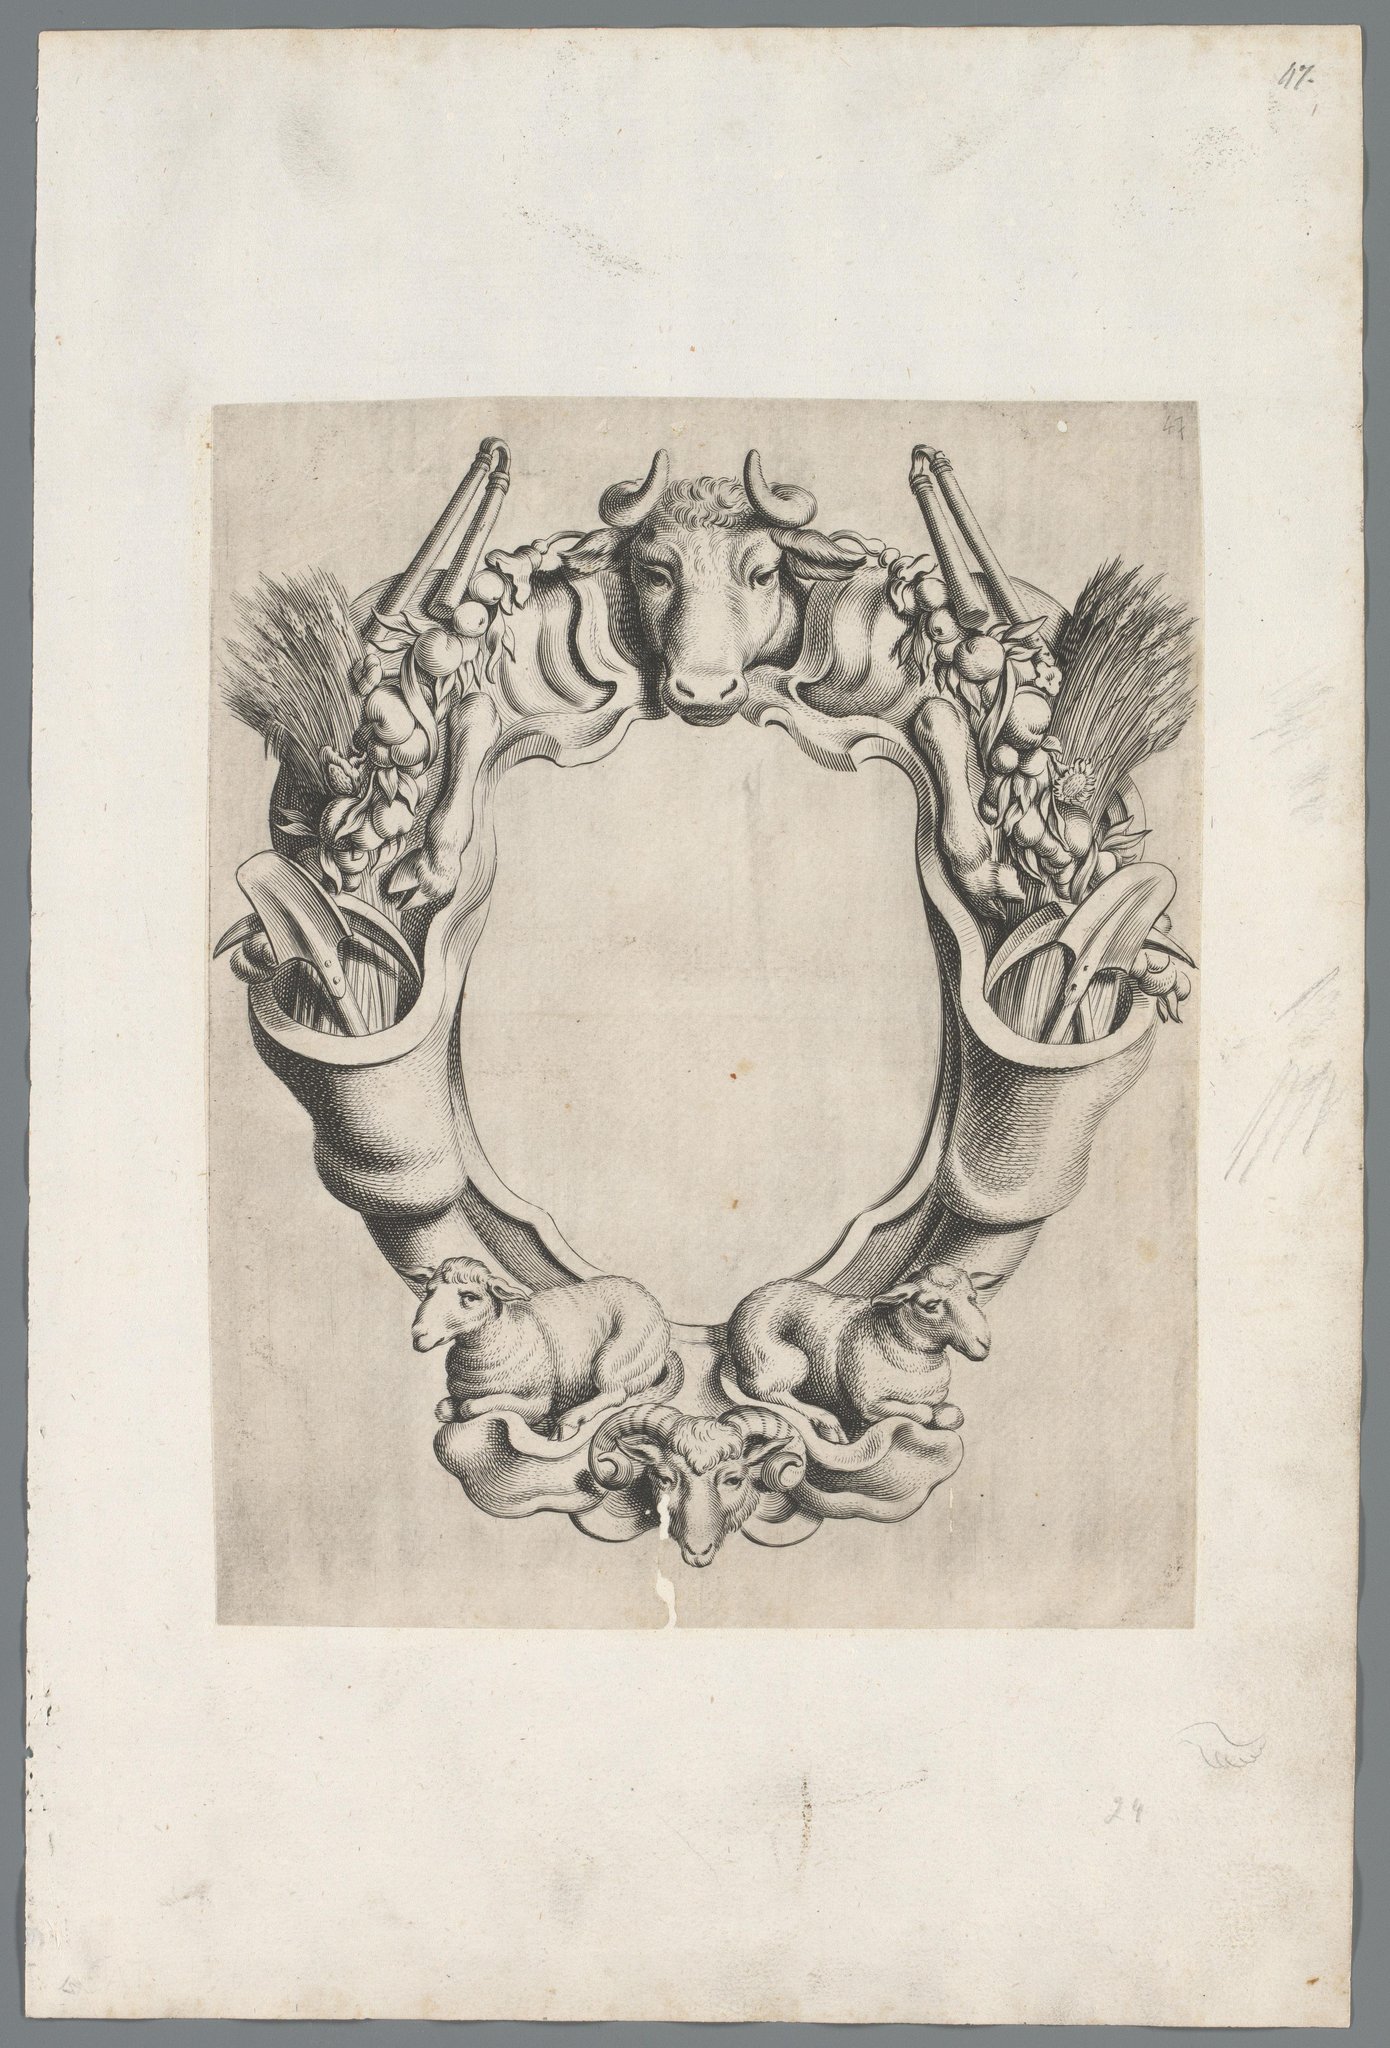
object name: print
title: Cartouche in kwabstijl met agrarisch thema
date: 1640-1674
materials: paper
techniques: engraving, etching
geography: amsterdam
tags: auricular ornament, lobe style ~ ornament, ornament ~ cartouche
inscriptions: collector's mark: Lugt 2228, collector's mark: Lugt 2760